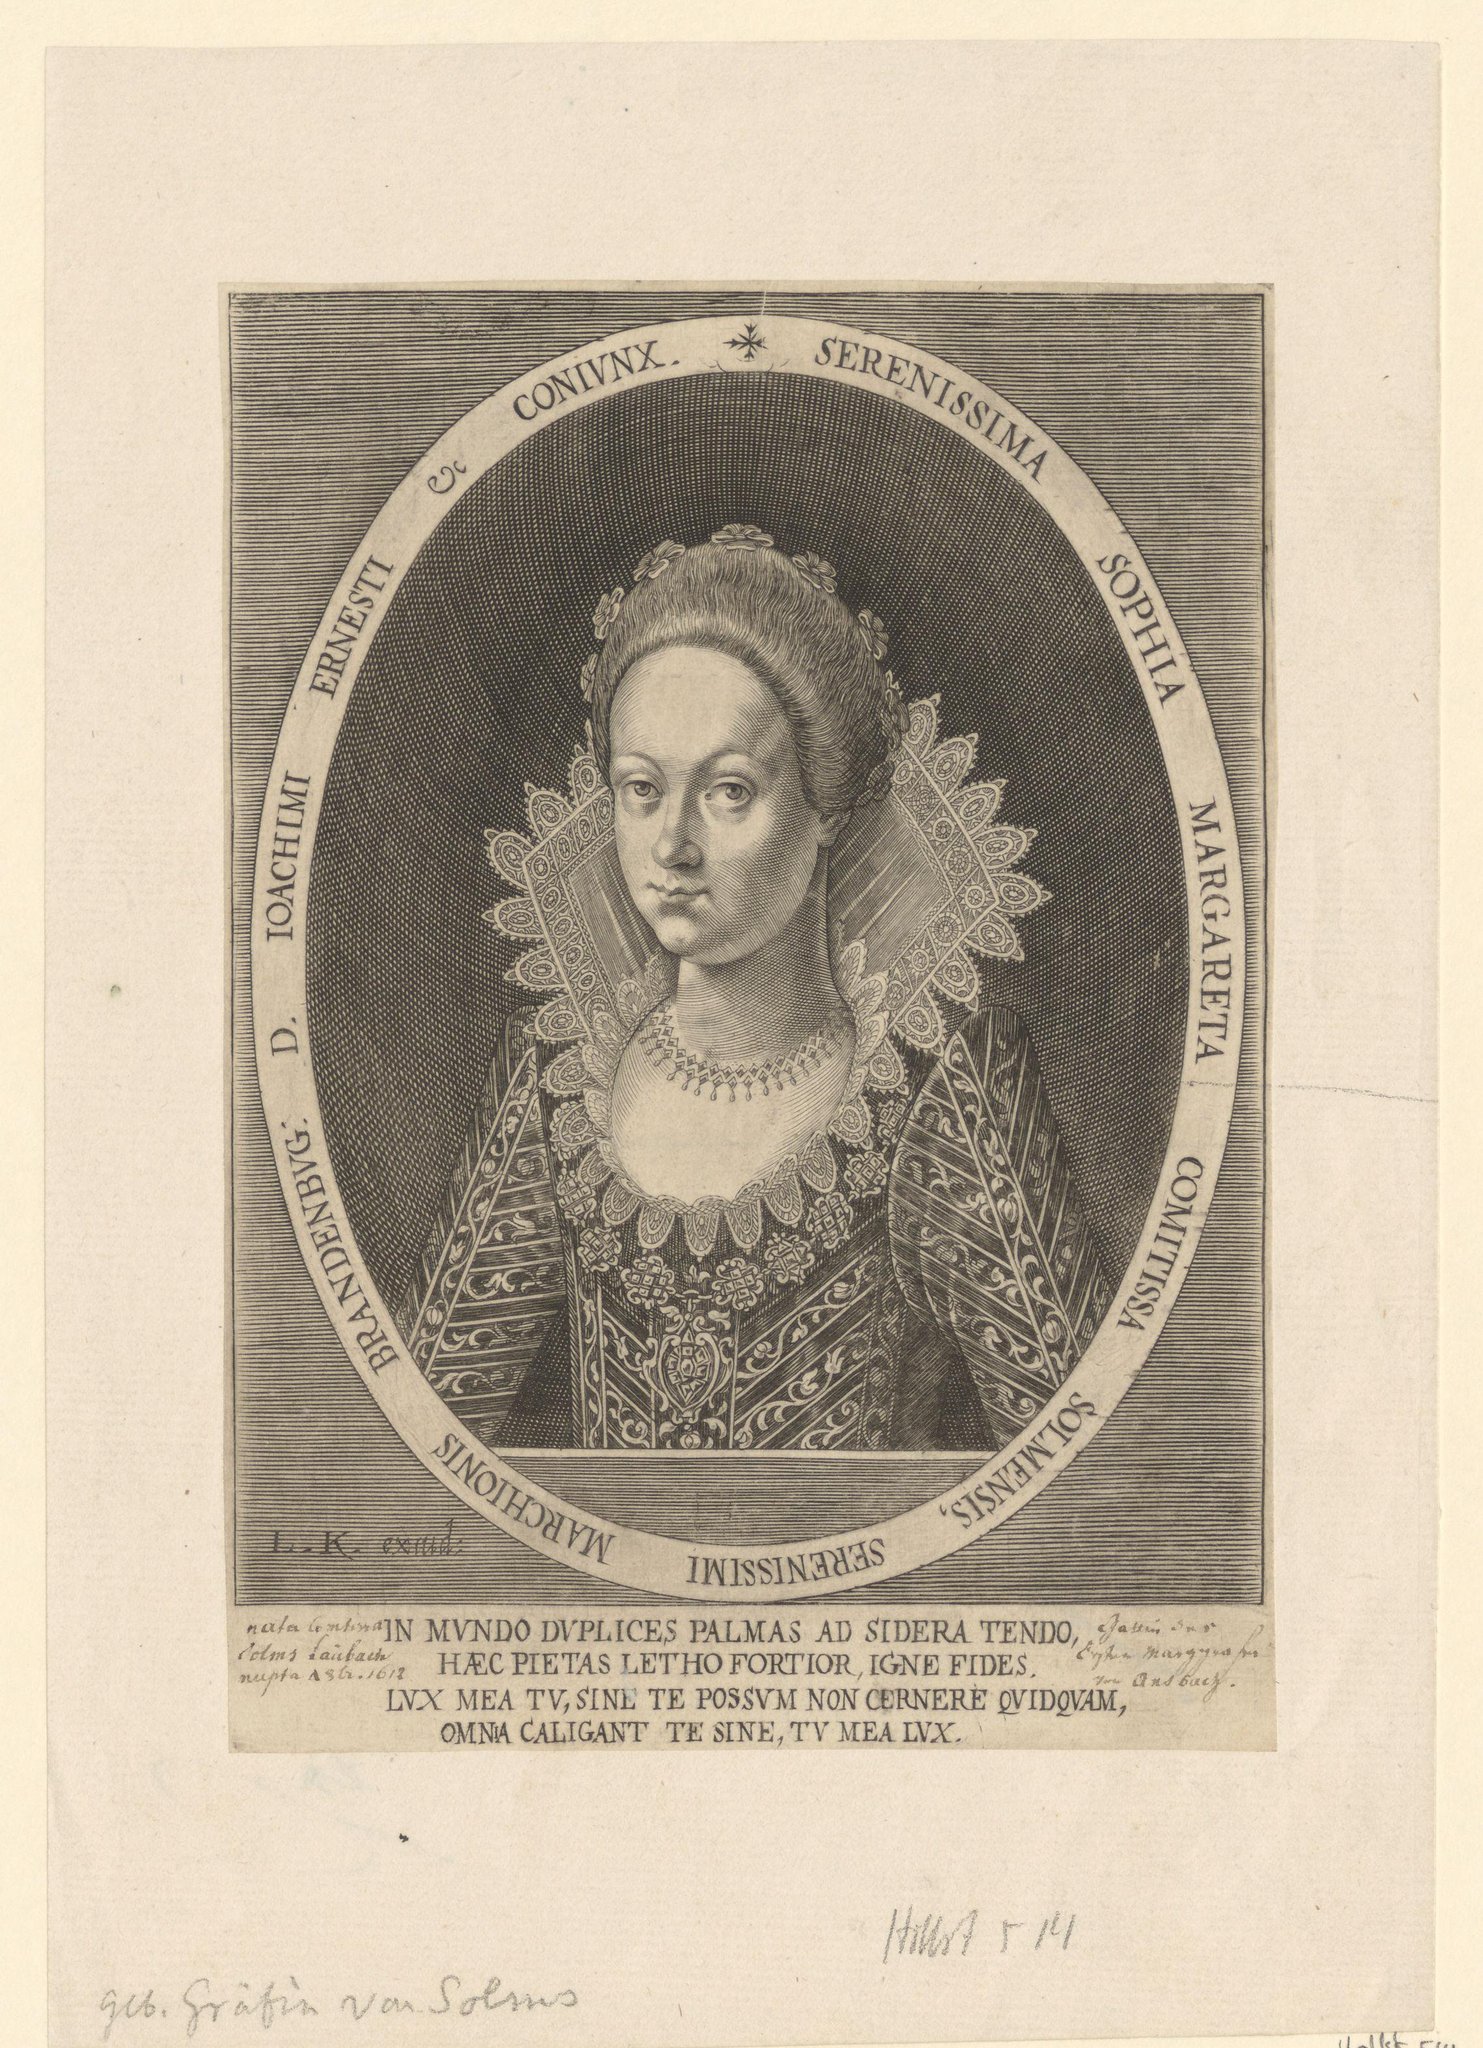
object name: print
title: Portret van Sophia Margaretha von Brandenburg-Ansbach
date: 1612-1637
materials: paper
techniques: engraving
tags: historical persons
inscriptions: collector's mark: Lugt 2228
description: Tekst in het Latijn in de omlijsting en in de ondermarge.